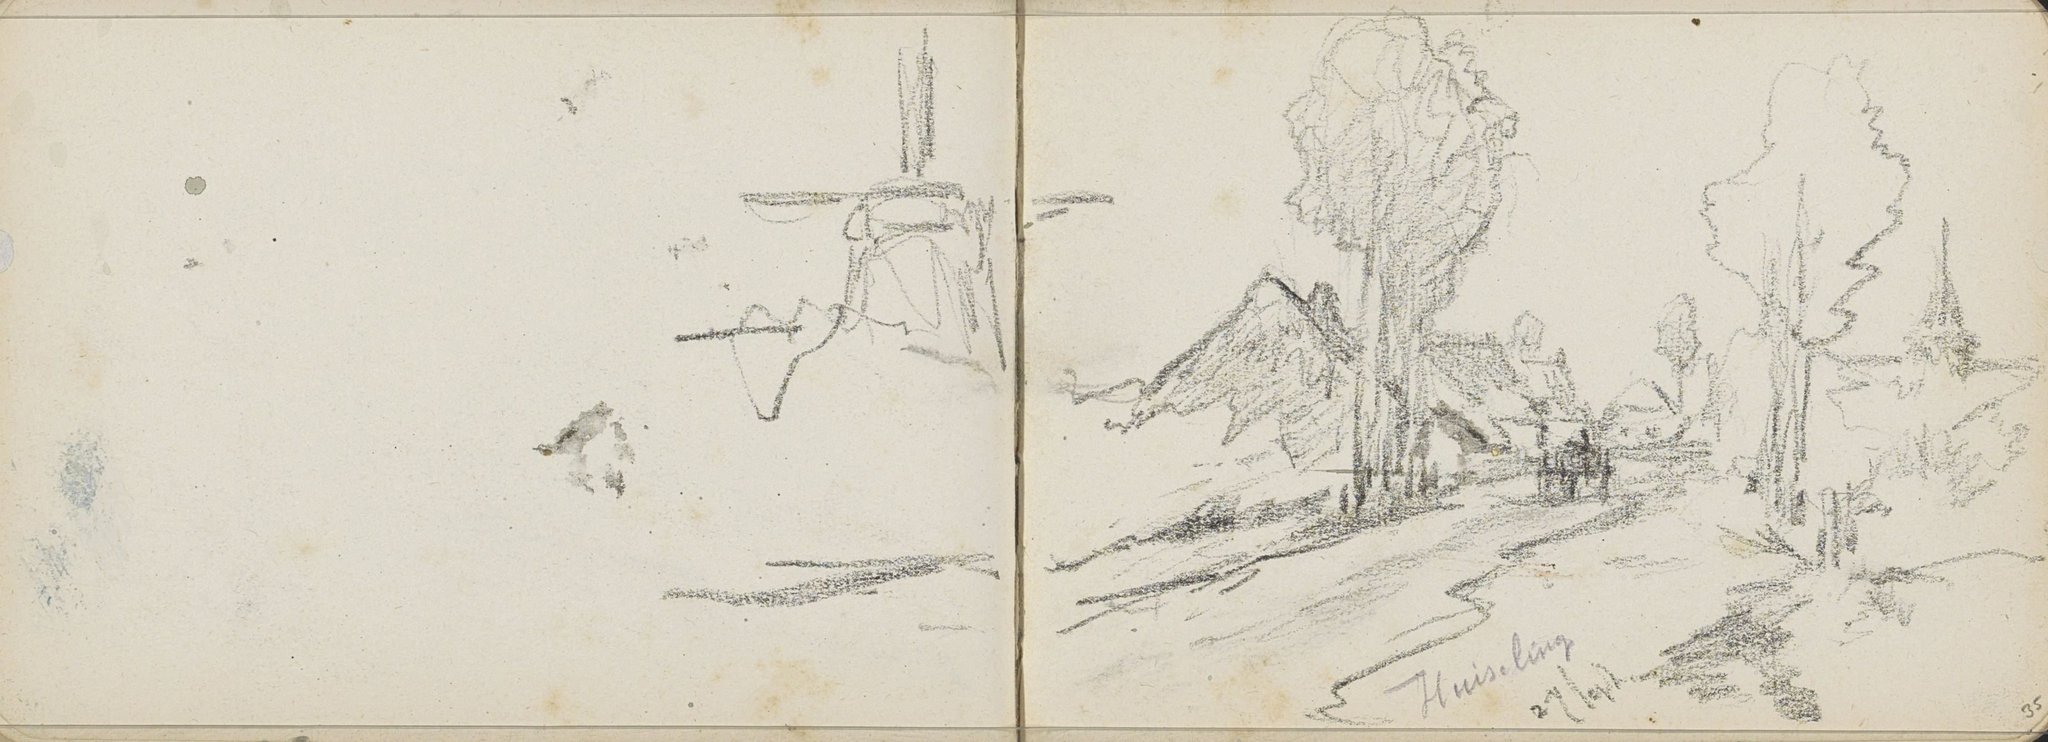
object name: sketchbook leaf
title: Kar op een dorpsstraat te Huisseling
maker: willem cornelis rip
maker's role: draughtsman, painter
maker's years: 1856-1922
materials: chalk, paper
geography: huisseling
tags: windmill, village street (+ city(-scape) with figures, staffage)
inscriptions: date and inscription: ‘Huiseling. 27 Sept’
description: Tevens een studie van een molen. Blad 34 verso en 35 recto uit een schetsboek met 44 bladen.